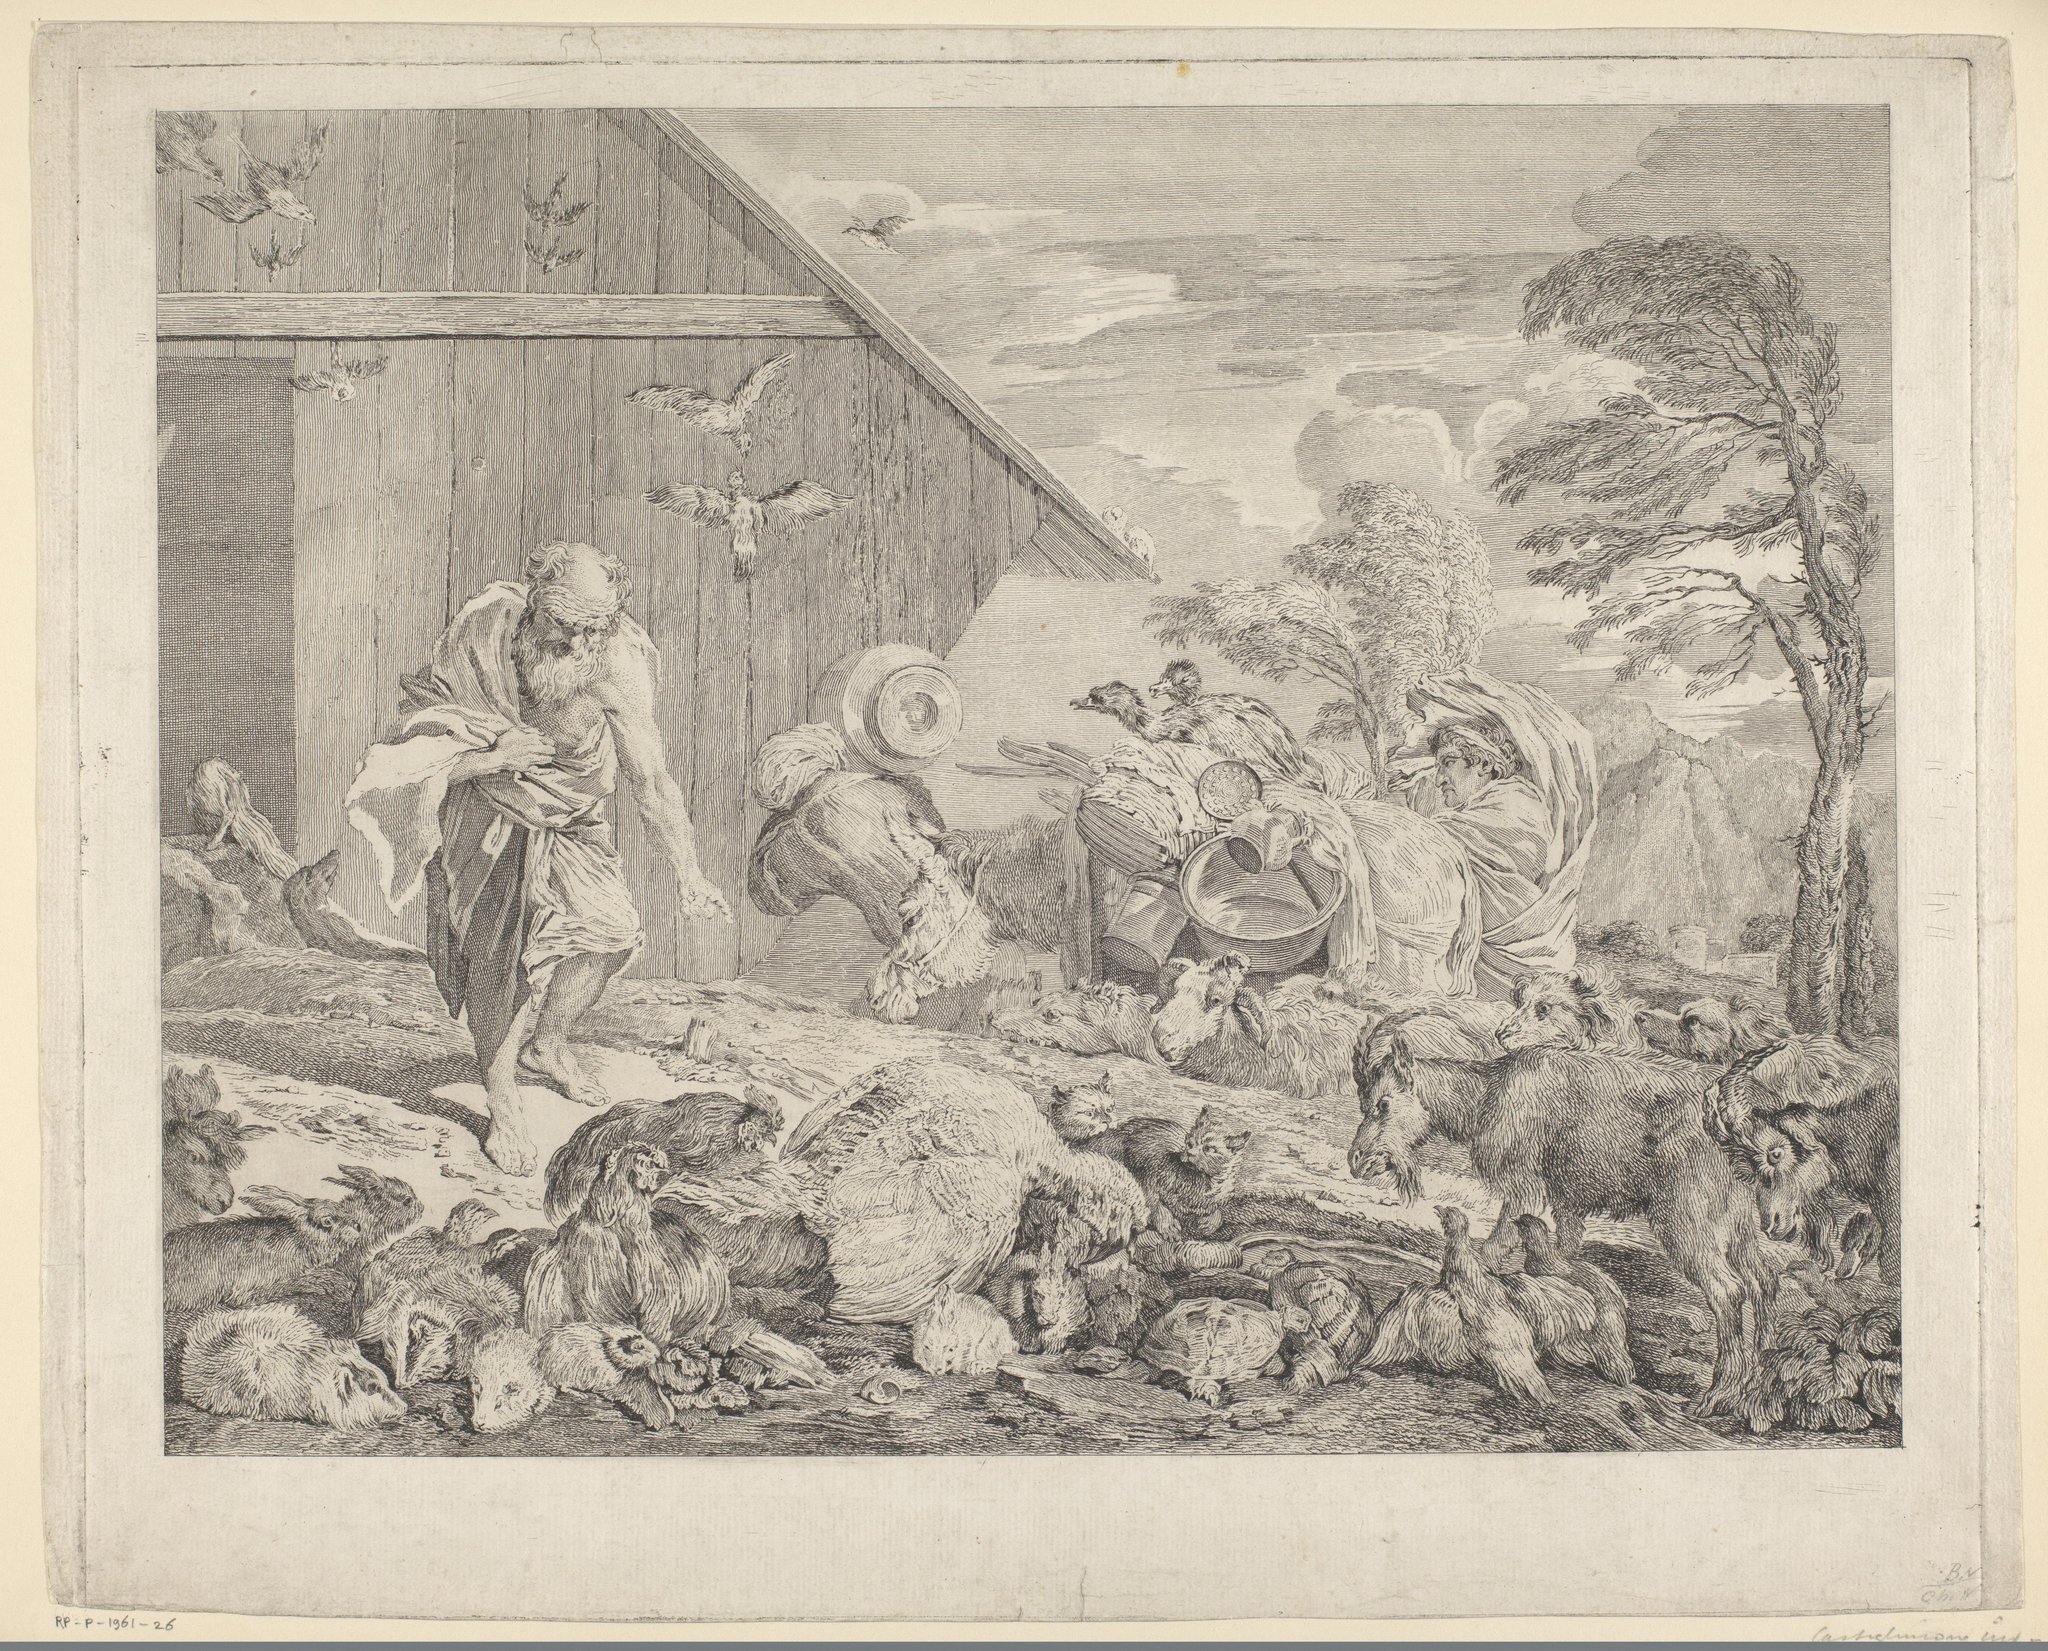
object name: print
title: Schilderijen in de koninklijke kunstcollecties te Dresden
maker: pierre aveline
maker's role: print maker, publisher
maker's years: 1654-1722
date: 1750-1757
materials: paper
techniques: etching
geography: france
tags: the building of the ark, and the embarkation (genesis 7:5-9)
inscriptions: collector's mark: Lugt 2760, collector's mark: Lugt 2228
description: Maakt deel uit van de 'Recueil d'estampes d'après les plus célèbres tableaux de la Galerie Royale de Dresde', verschenen in twee delen in 1753 en 1757, met in totaal 100 prenten naar schilderijen in de koninklijke kunstcollecties te Dresden.